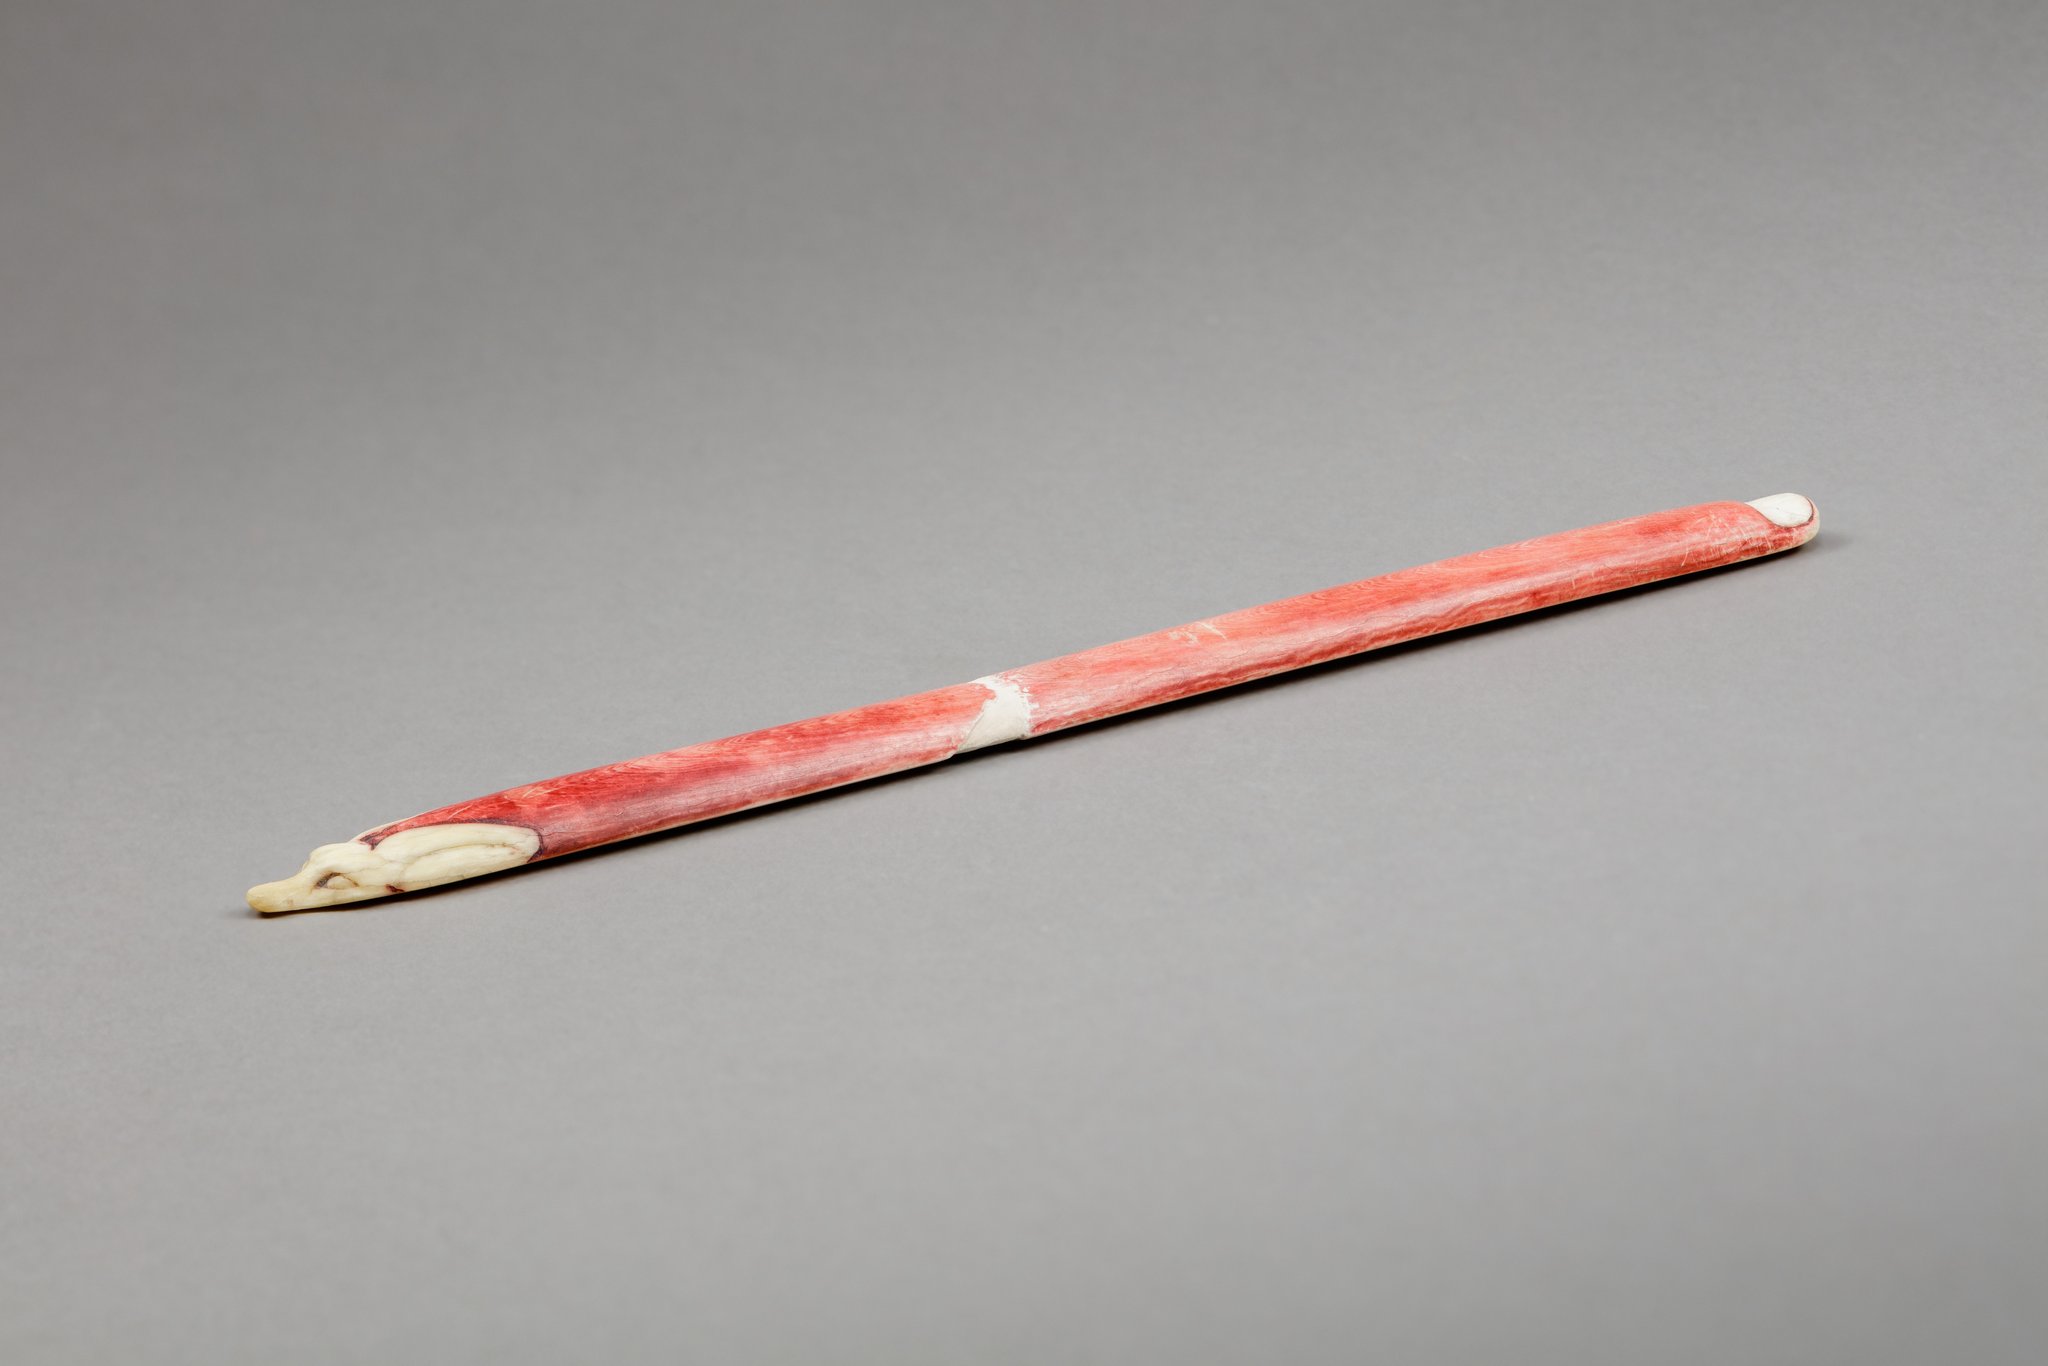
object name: throw stick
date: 1400-1295 BCE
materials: ivory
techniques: tinting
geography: egypt